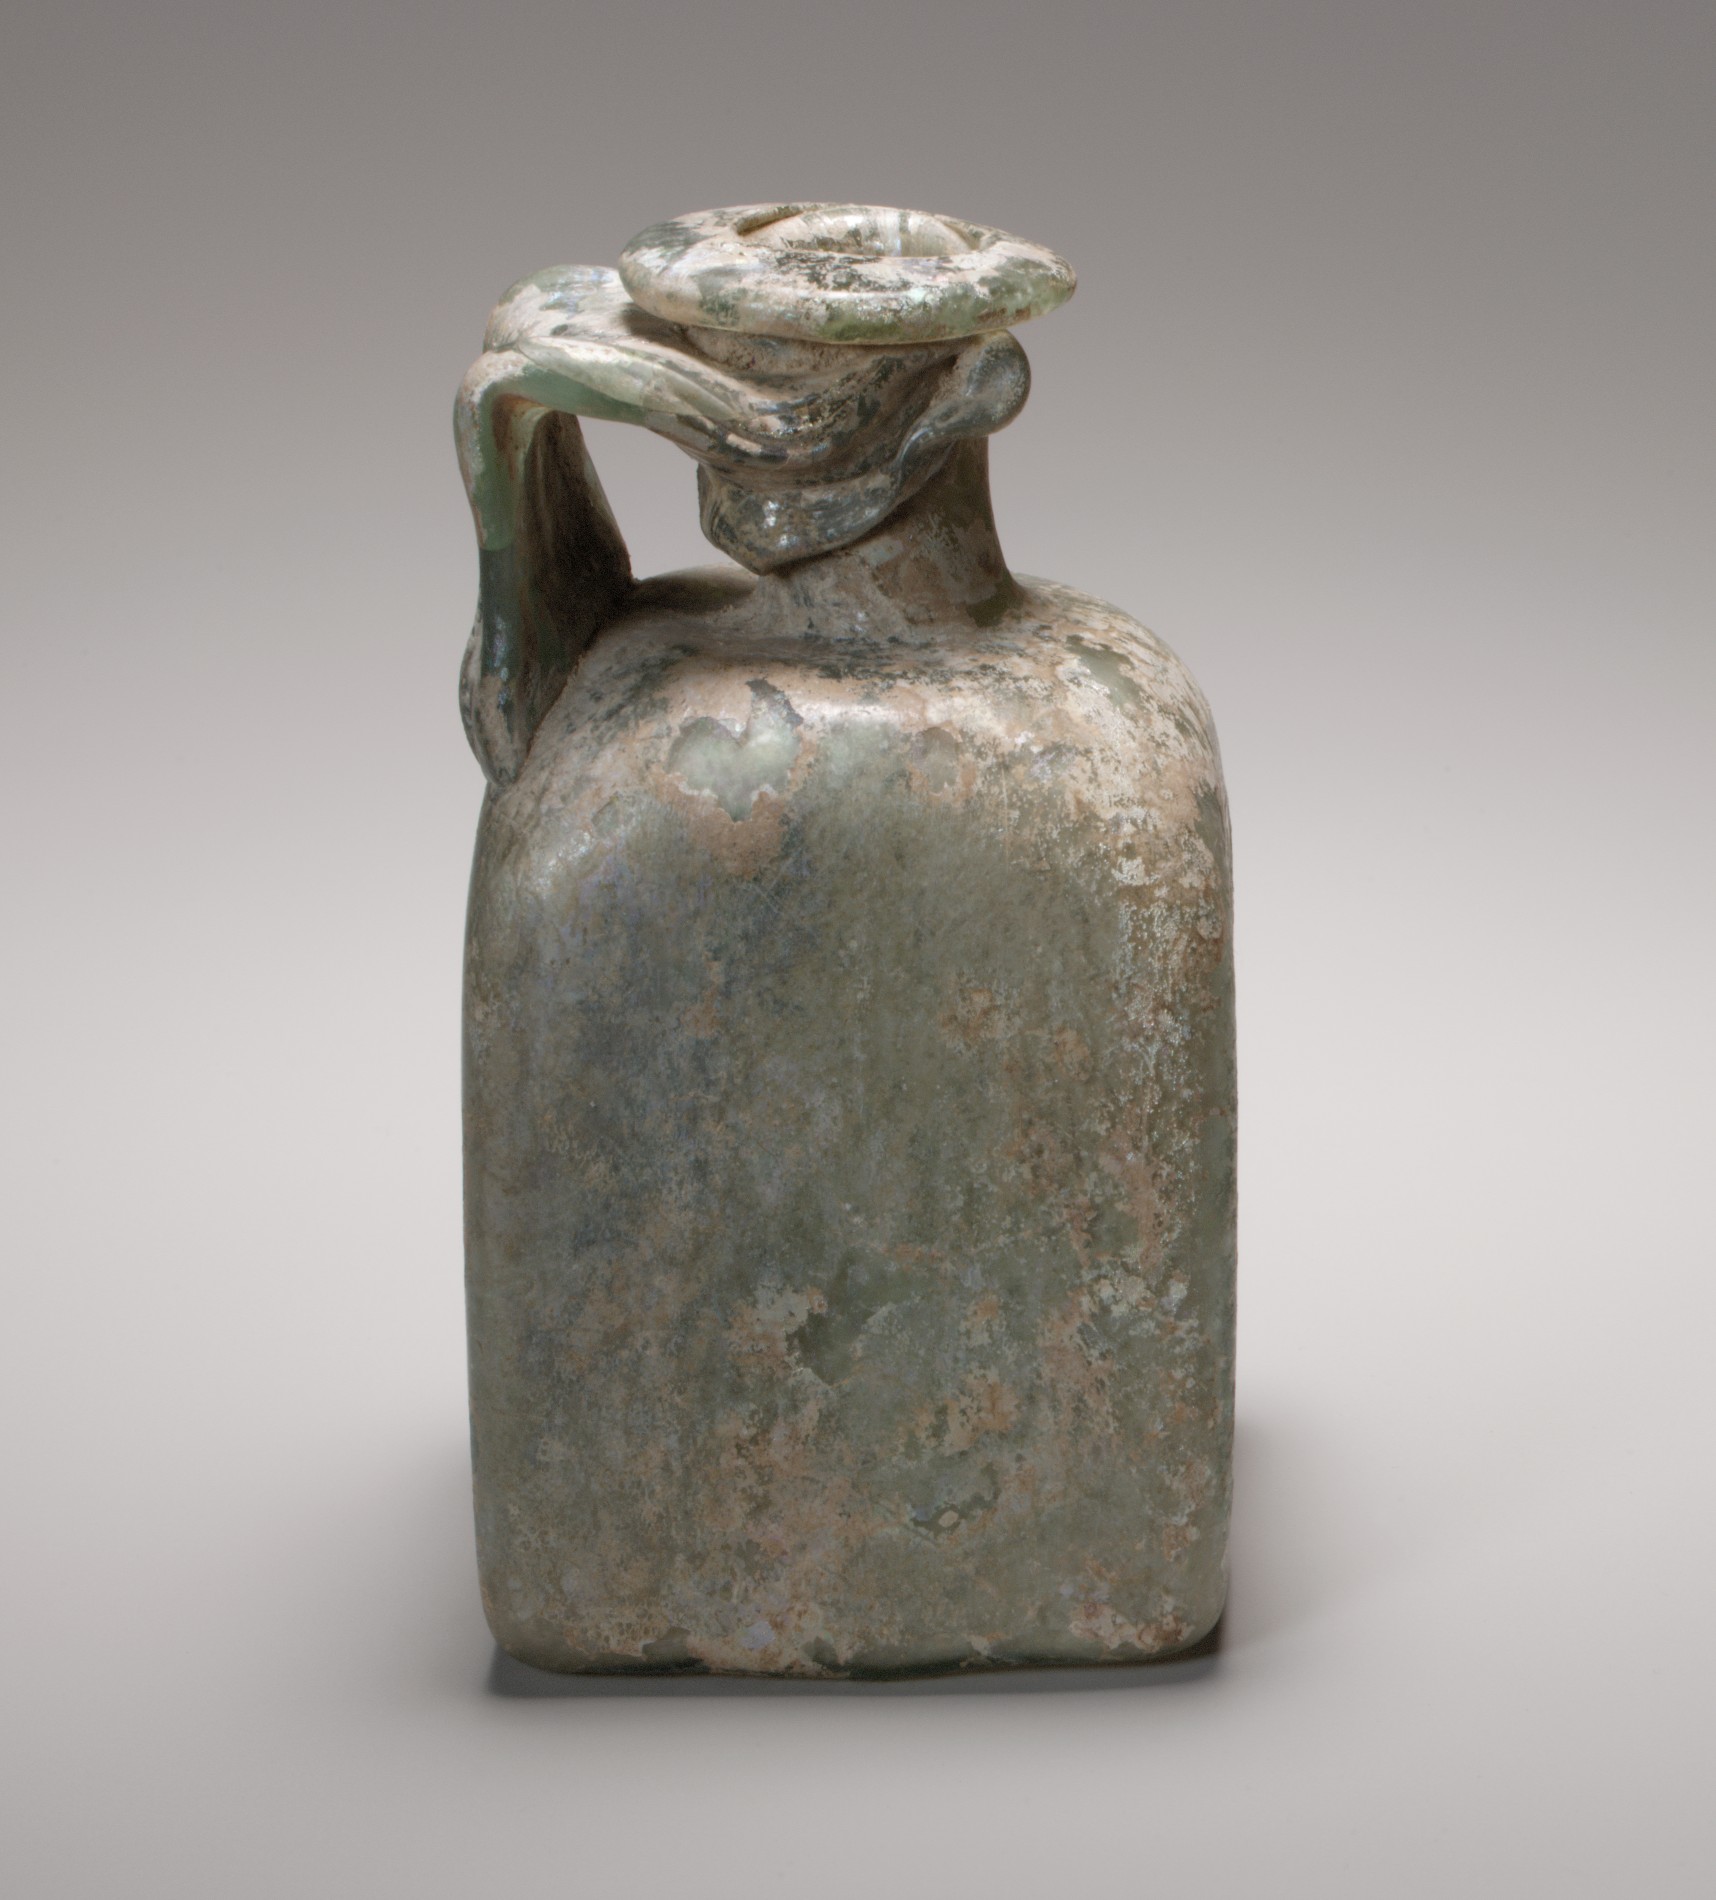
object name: bottle, square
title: Glass square bottle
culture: roman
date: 101-300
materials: glass